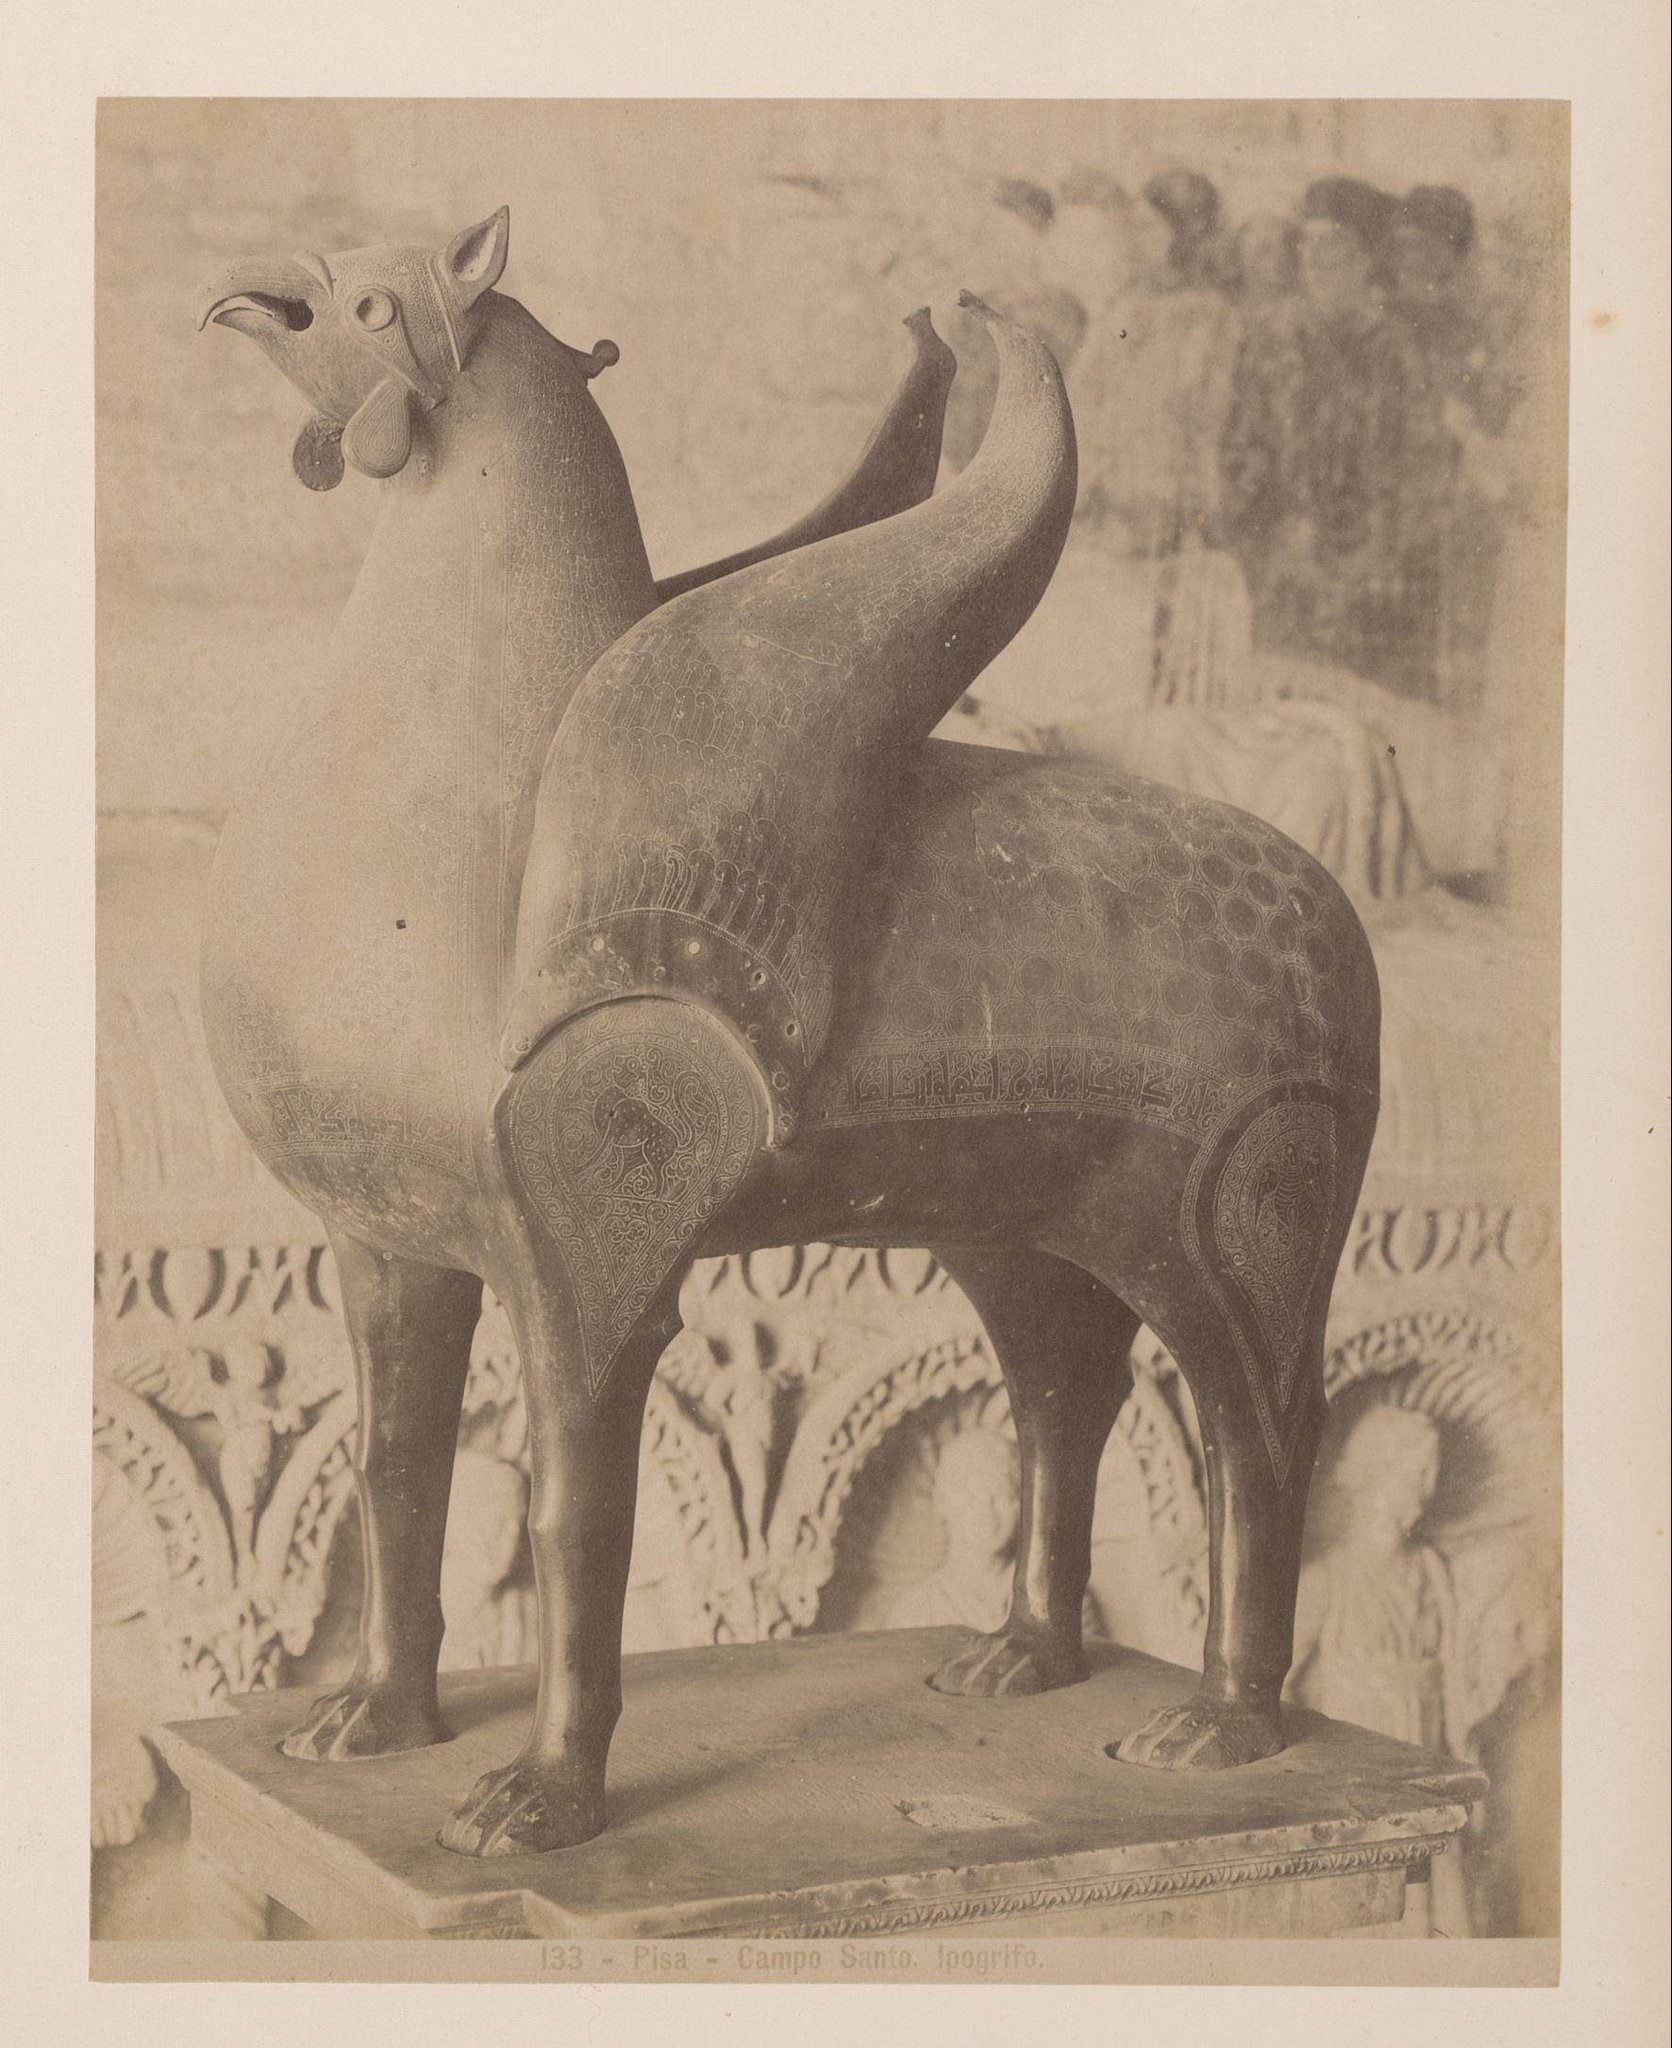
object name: album leaf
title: Sculptuur van een griffioen in het Camposanto te Pisa, Italië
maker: giacomo brogi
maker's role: fotograaf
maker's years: 1822-1881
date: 1860-1881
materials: paper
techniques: albumen print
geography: pisa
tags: griffin (lion/eagle); 'griffo' (ripa), piece of sculpture, reproduction of a piece of sculpture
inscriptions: number: ‘133’